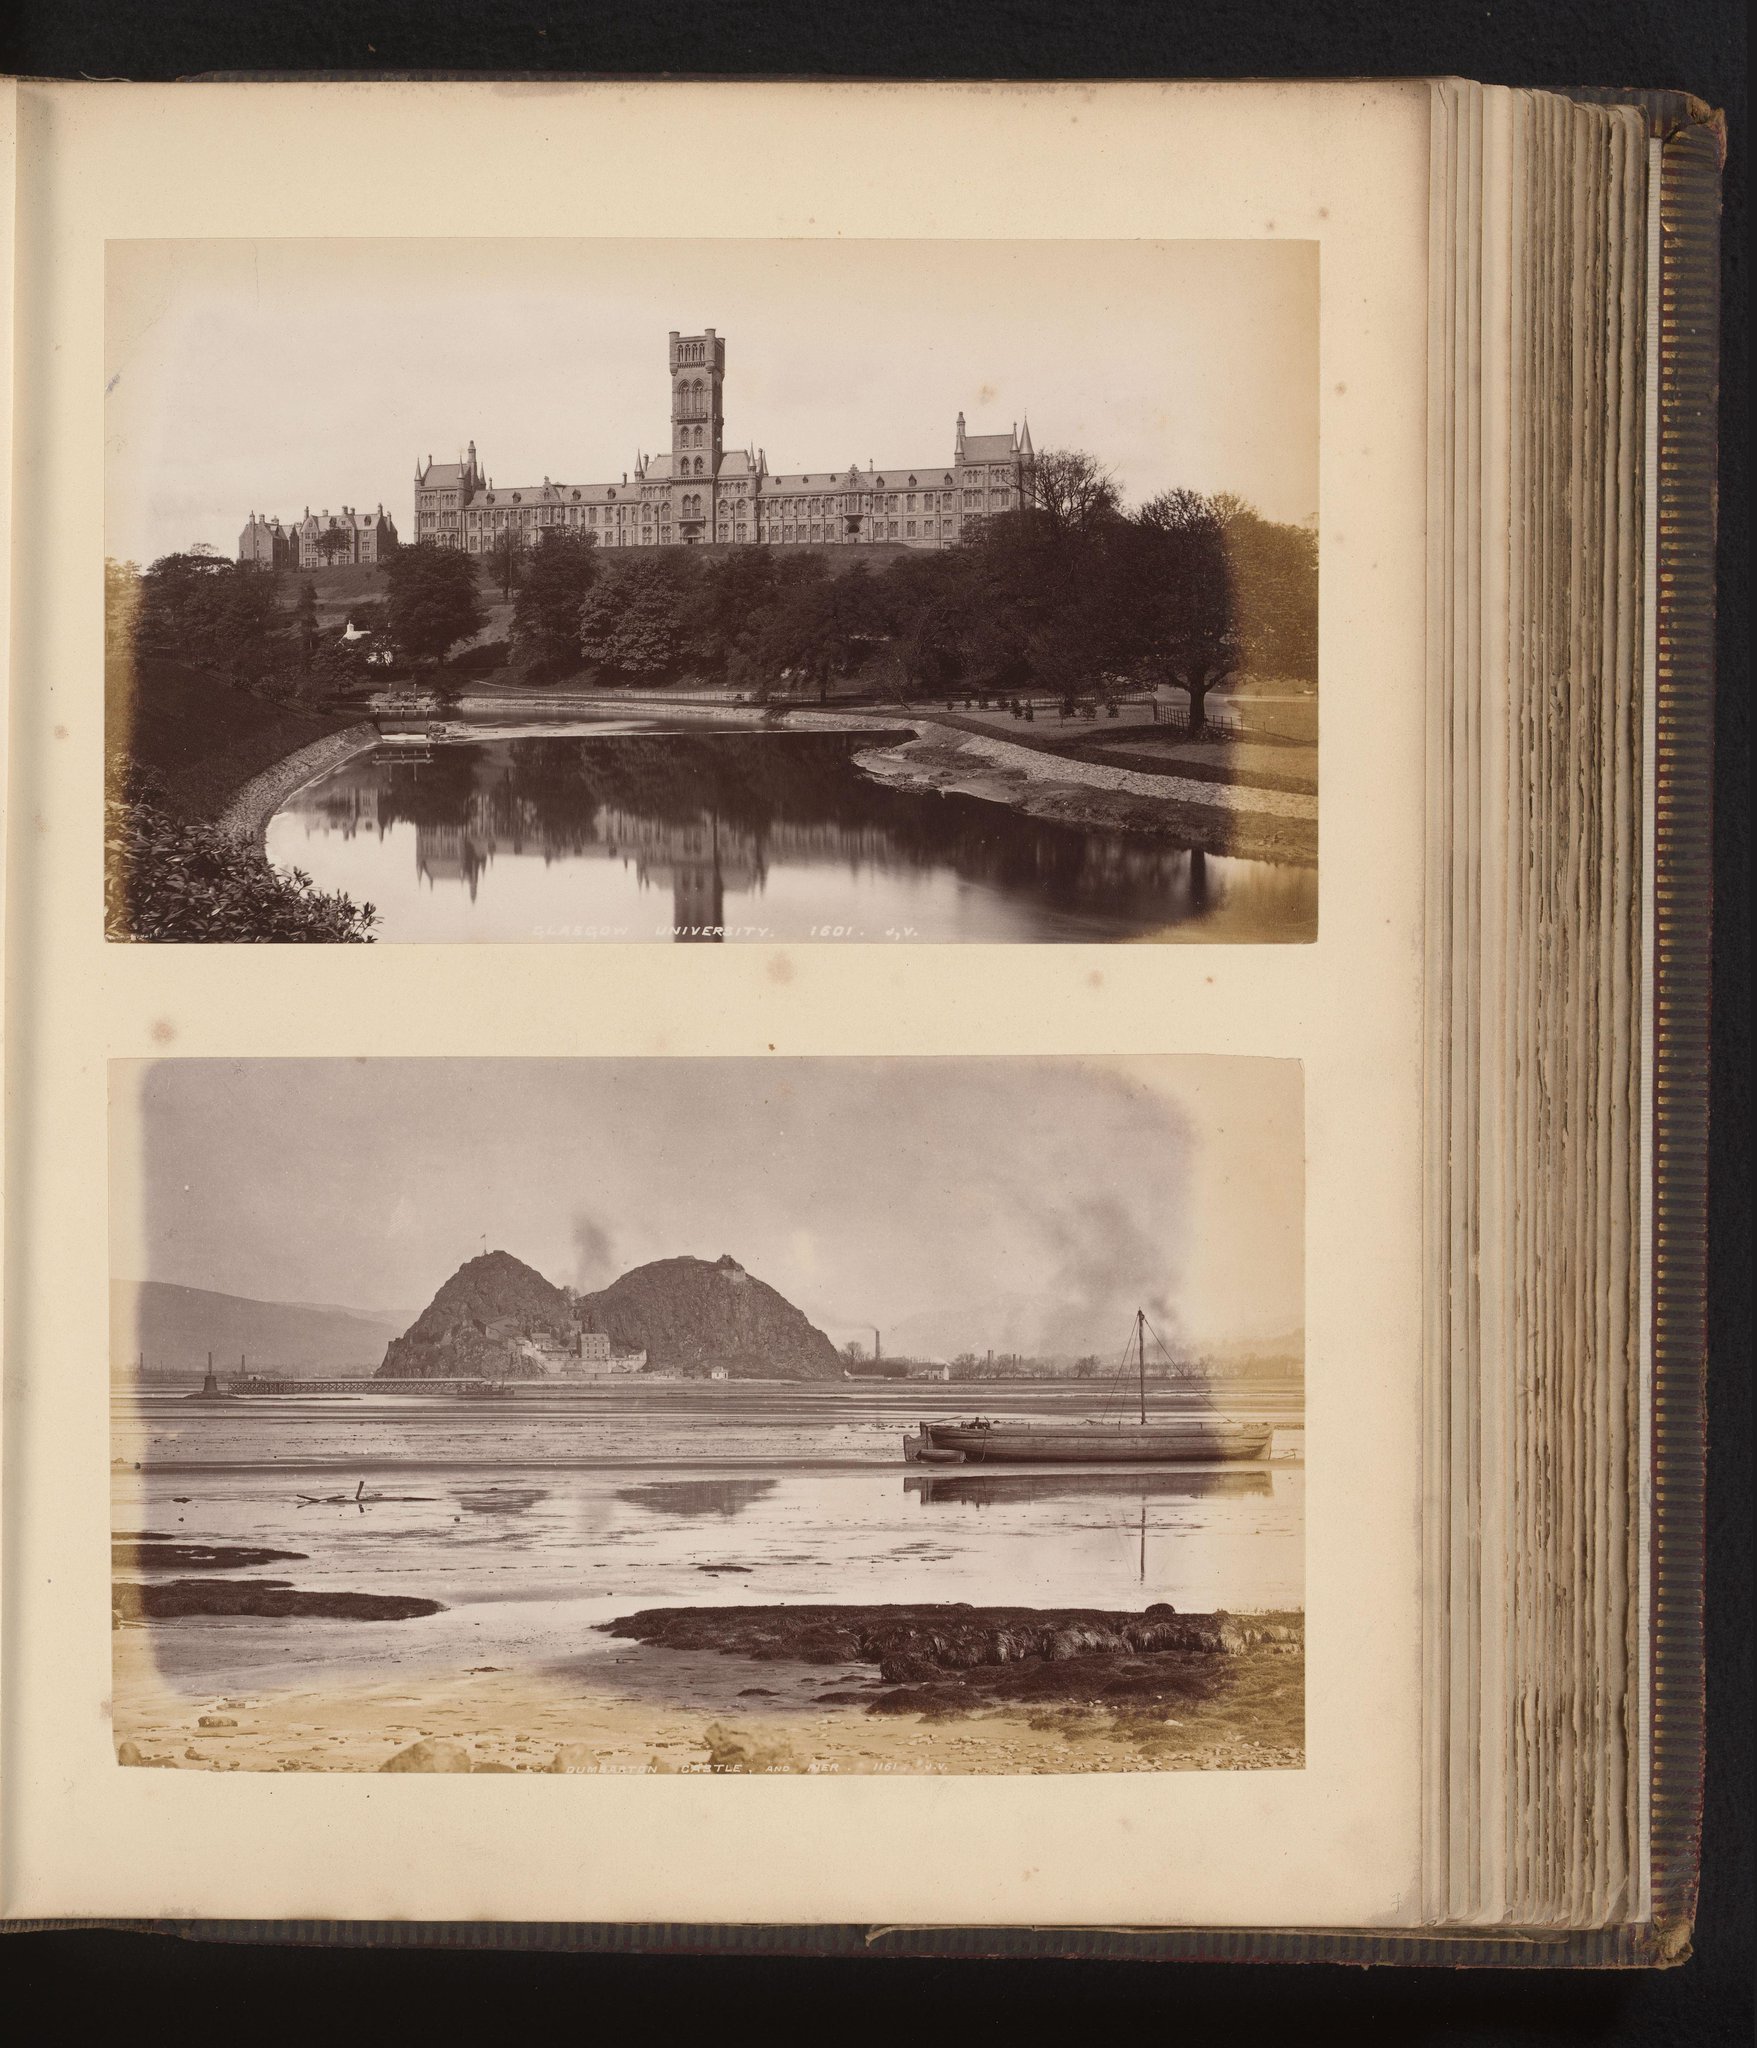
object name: photograph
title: Dumbarton Castle and pier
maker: Anonymous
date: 1875-1885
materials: photographic support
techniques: albumen print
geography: dumbarton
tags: landscapes with waters, waterscapes, seascapes (in the temperate zone), landscape with tower or castle, university, glasgow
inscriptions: number: ‘1161, J.V.’, number: ‘1601, J.V.’